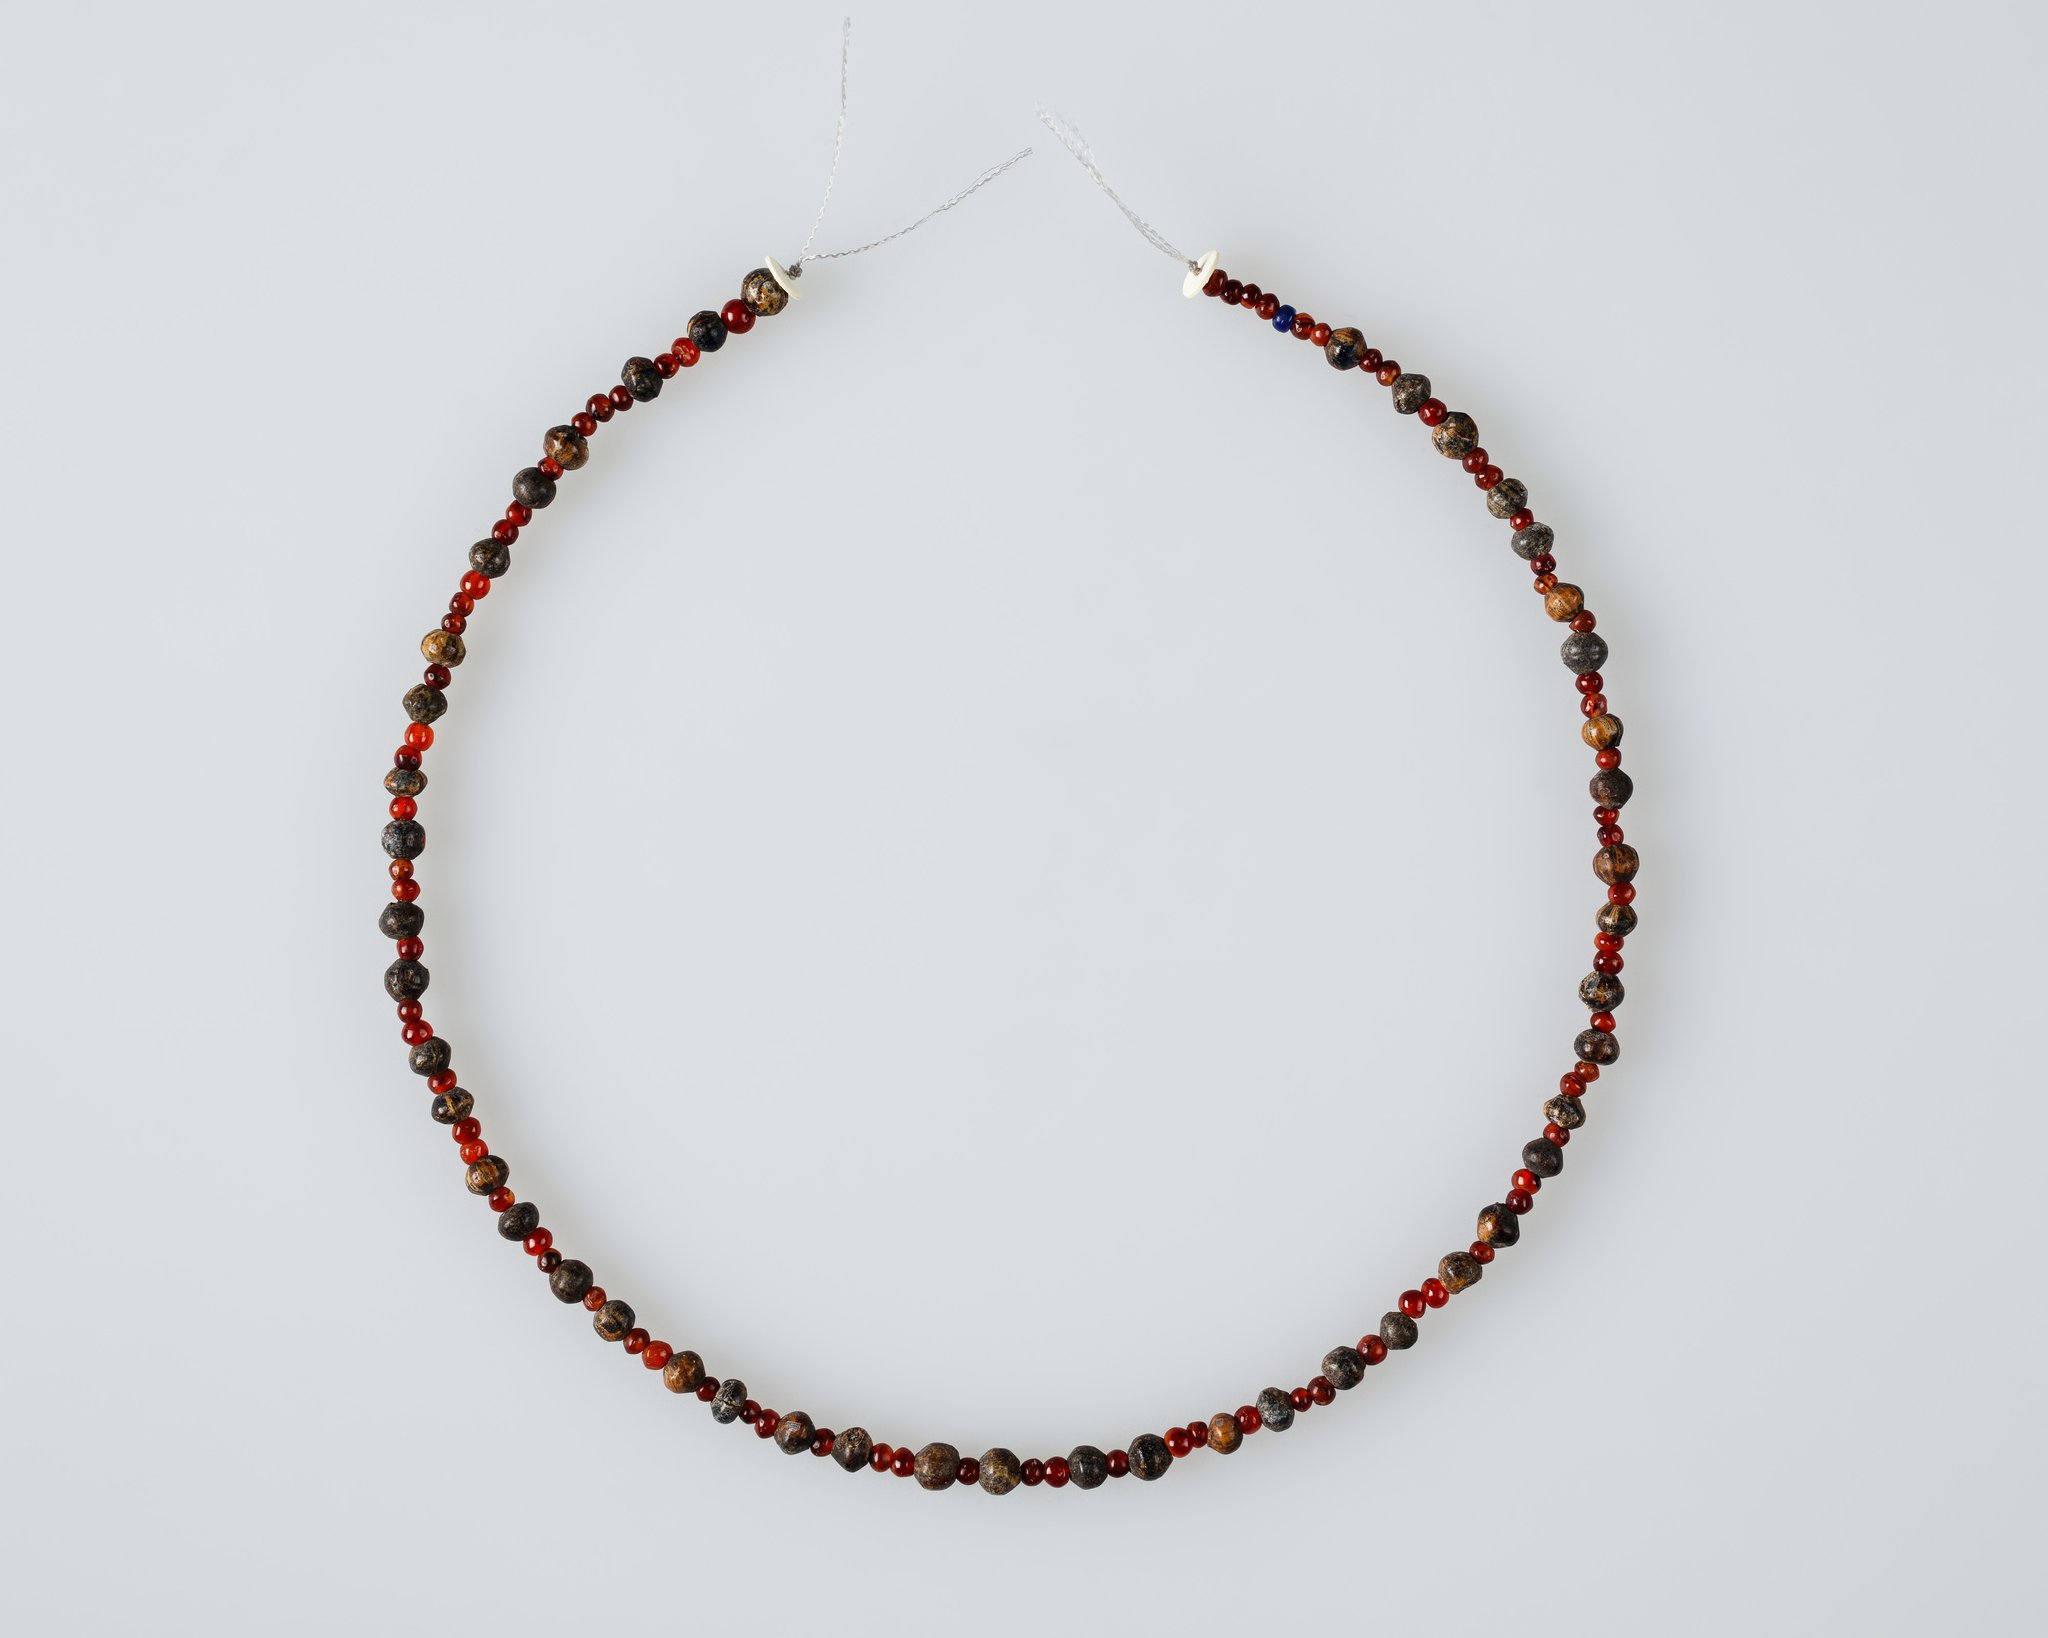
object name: bead, string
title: String of beads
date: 30 BCE-364 CE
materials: gemstone, glass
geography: nubia